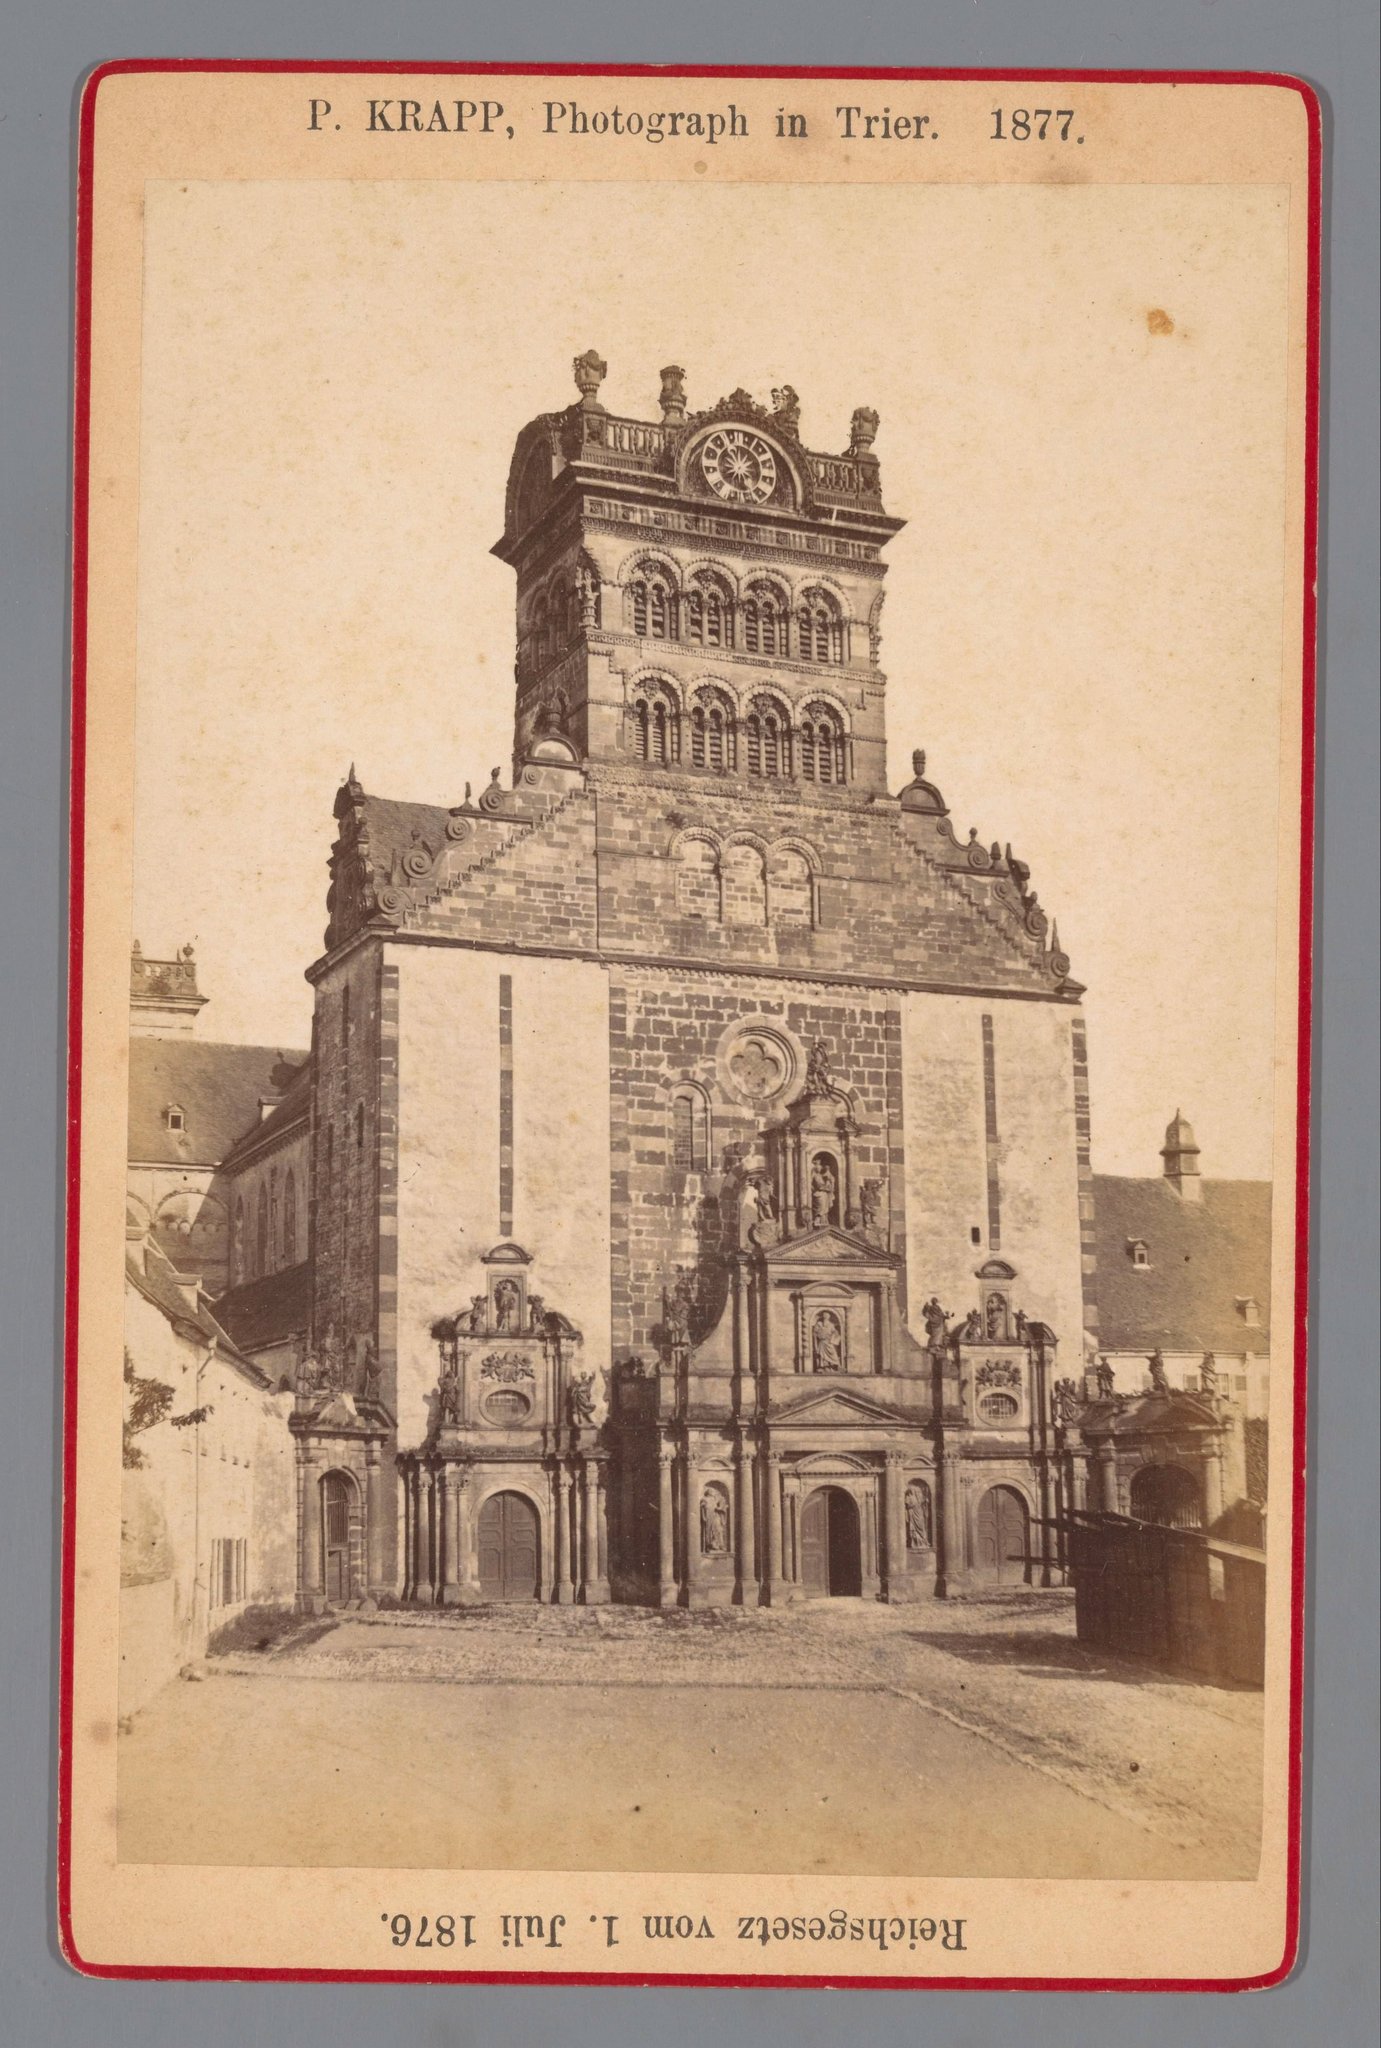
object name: photograph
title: De Sint-Matthiaskerk in Trier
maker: p. krapp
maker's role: publisher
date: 1876-1877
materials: cardboard, photographic support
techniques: albumen print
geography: trier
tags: church (exterior)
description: Gezicht op de Sint-Matthiaskerk van de benedictijnerabdij in Trier.